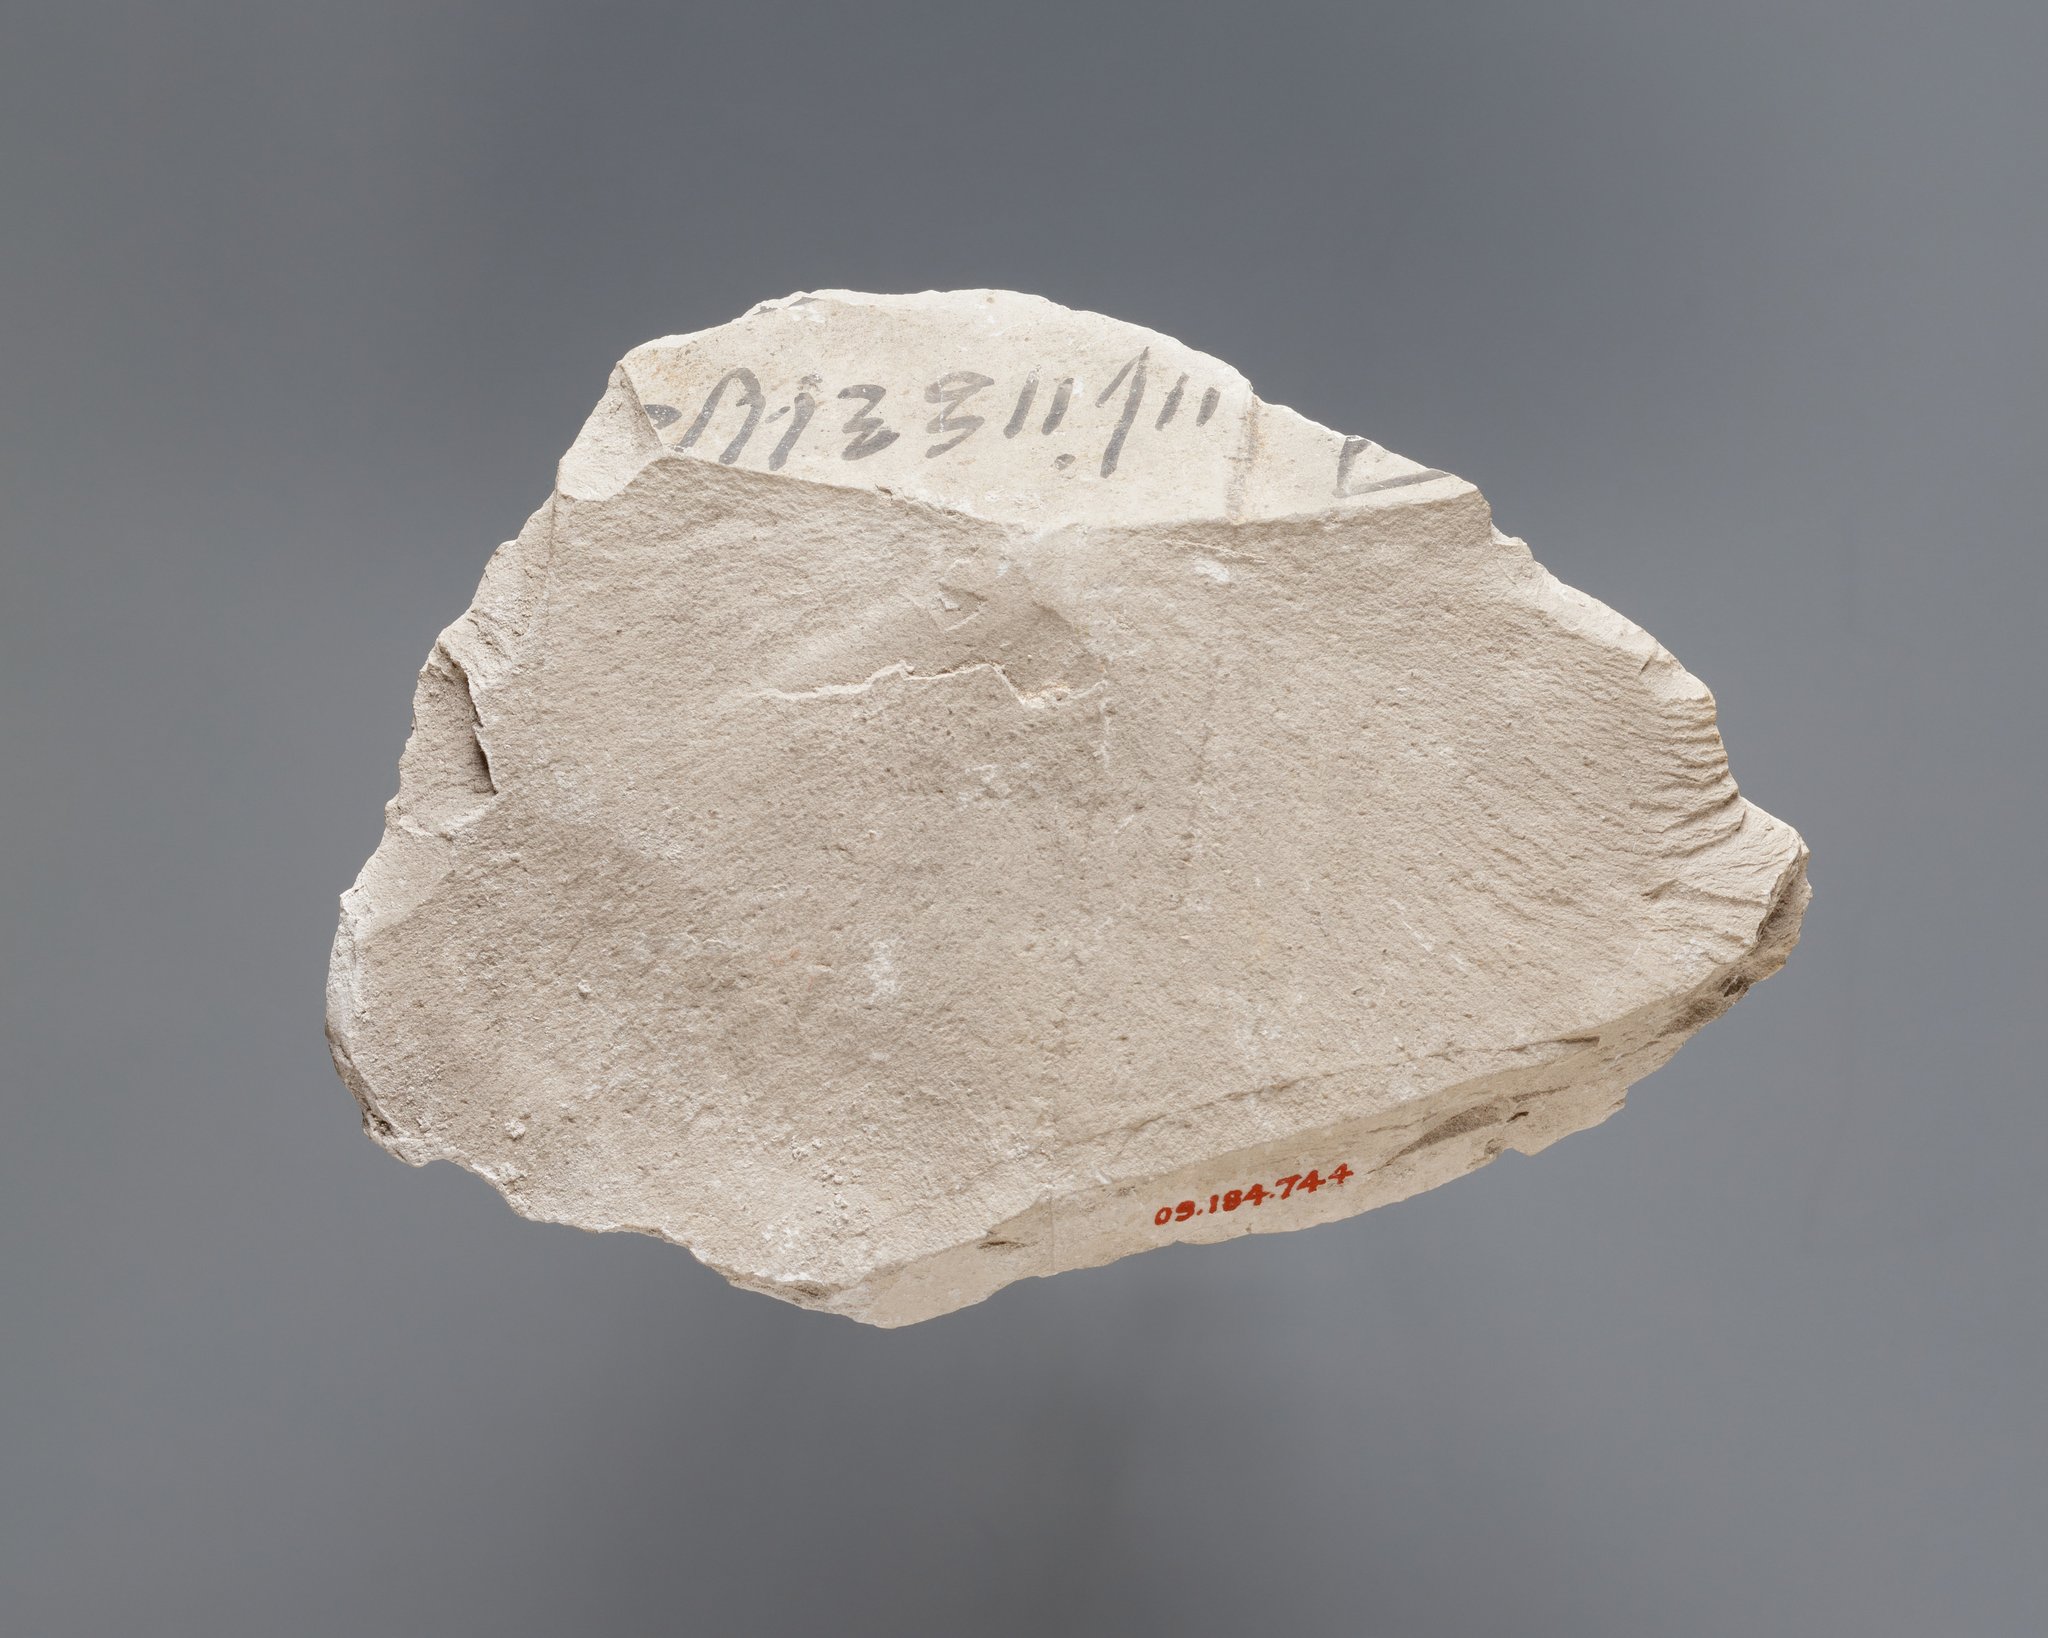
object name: ostracon, hieratic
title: Hieratic ostracon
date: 1295-1070 BCE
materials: ink, limestone, paint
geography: egypt